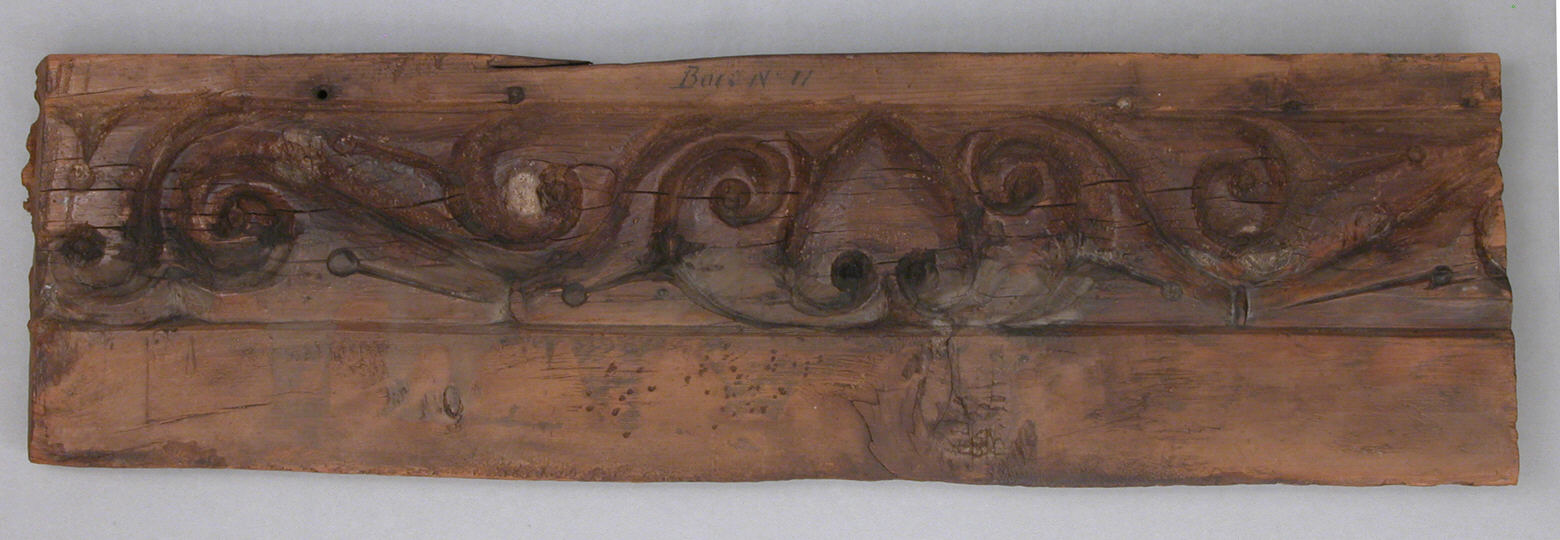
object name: panel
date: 801-900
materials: wood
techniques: carving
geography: egypt